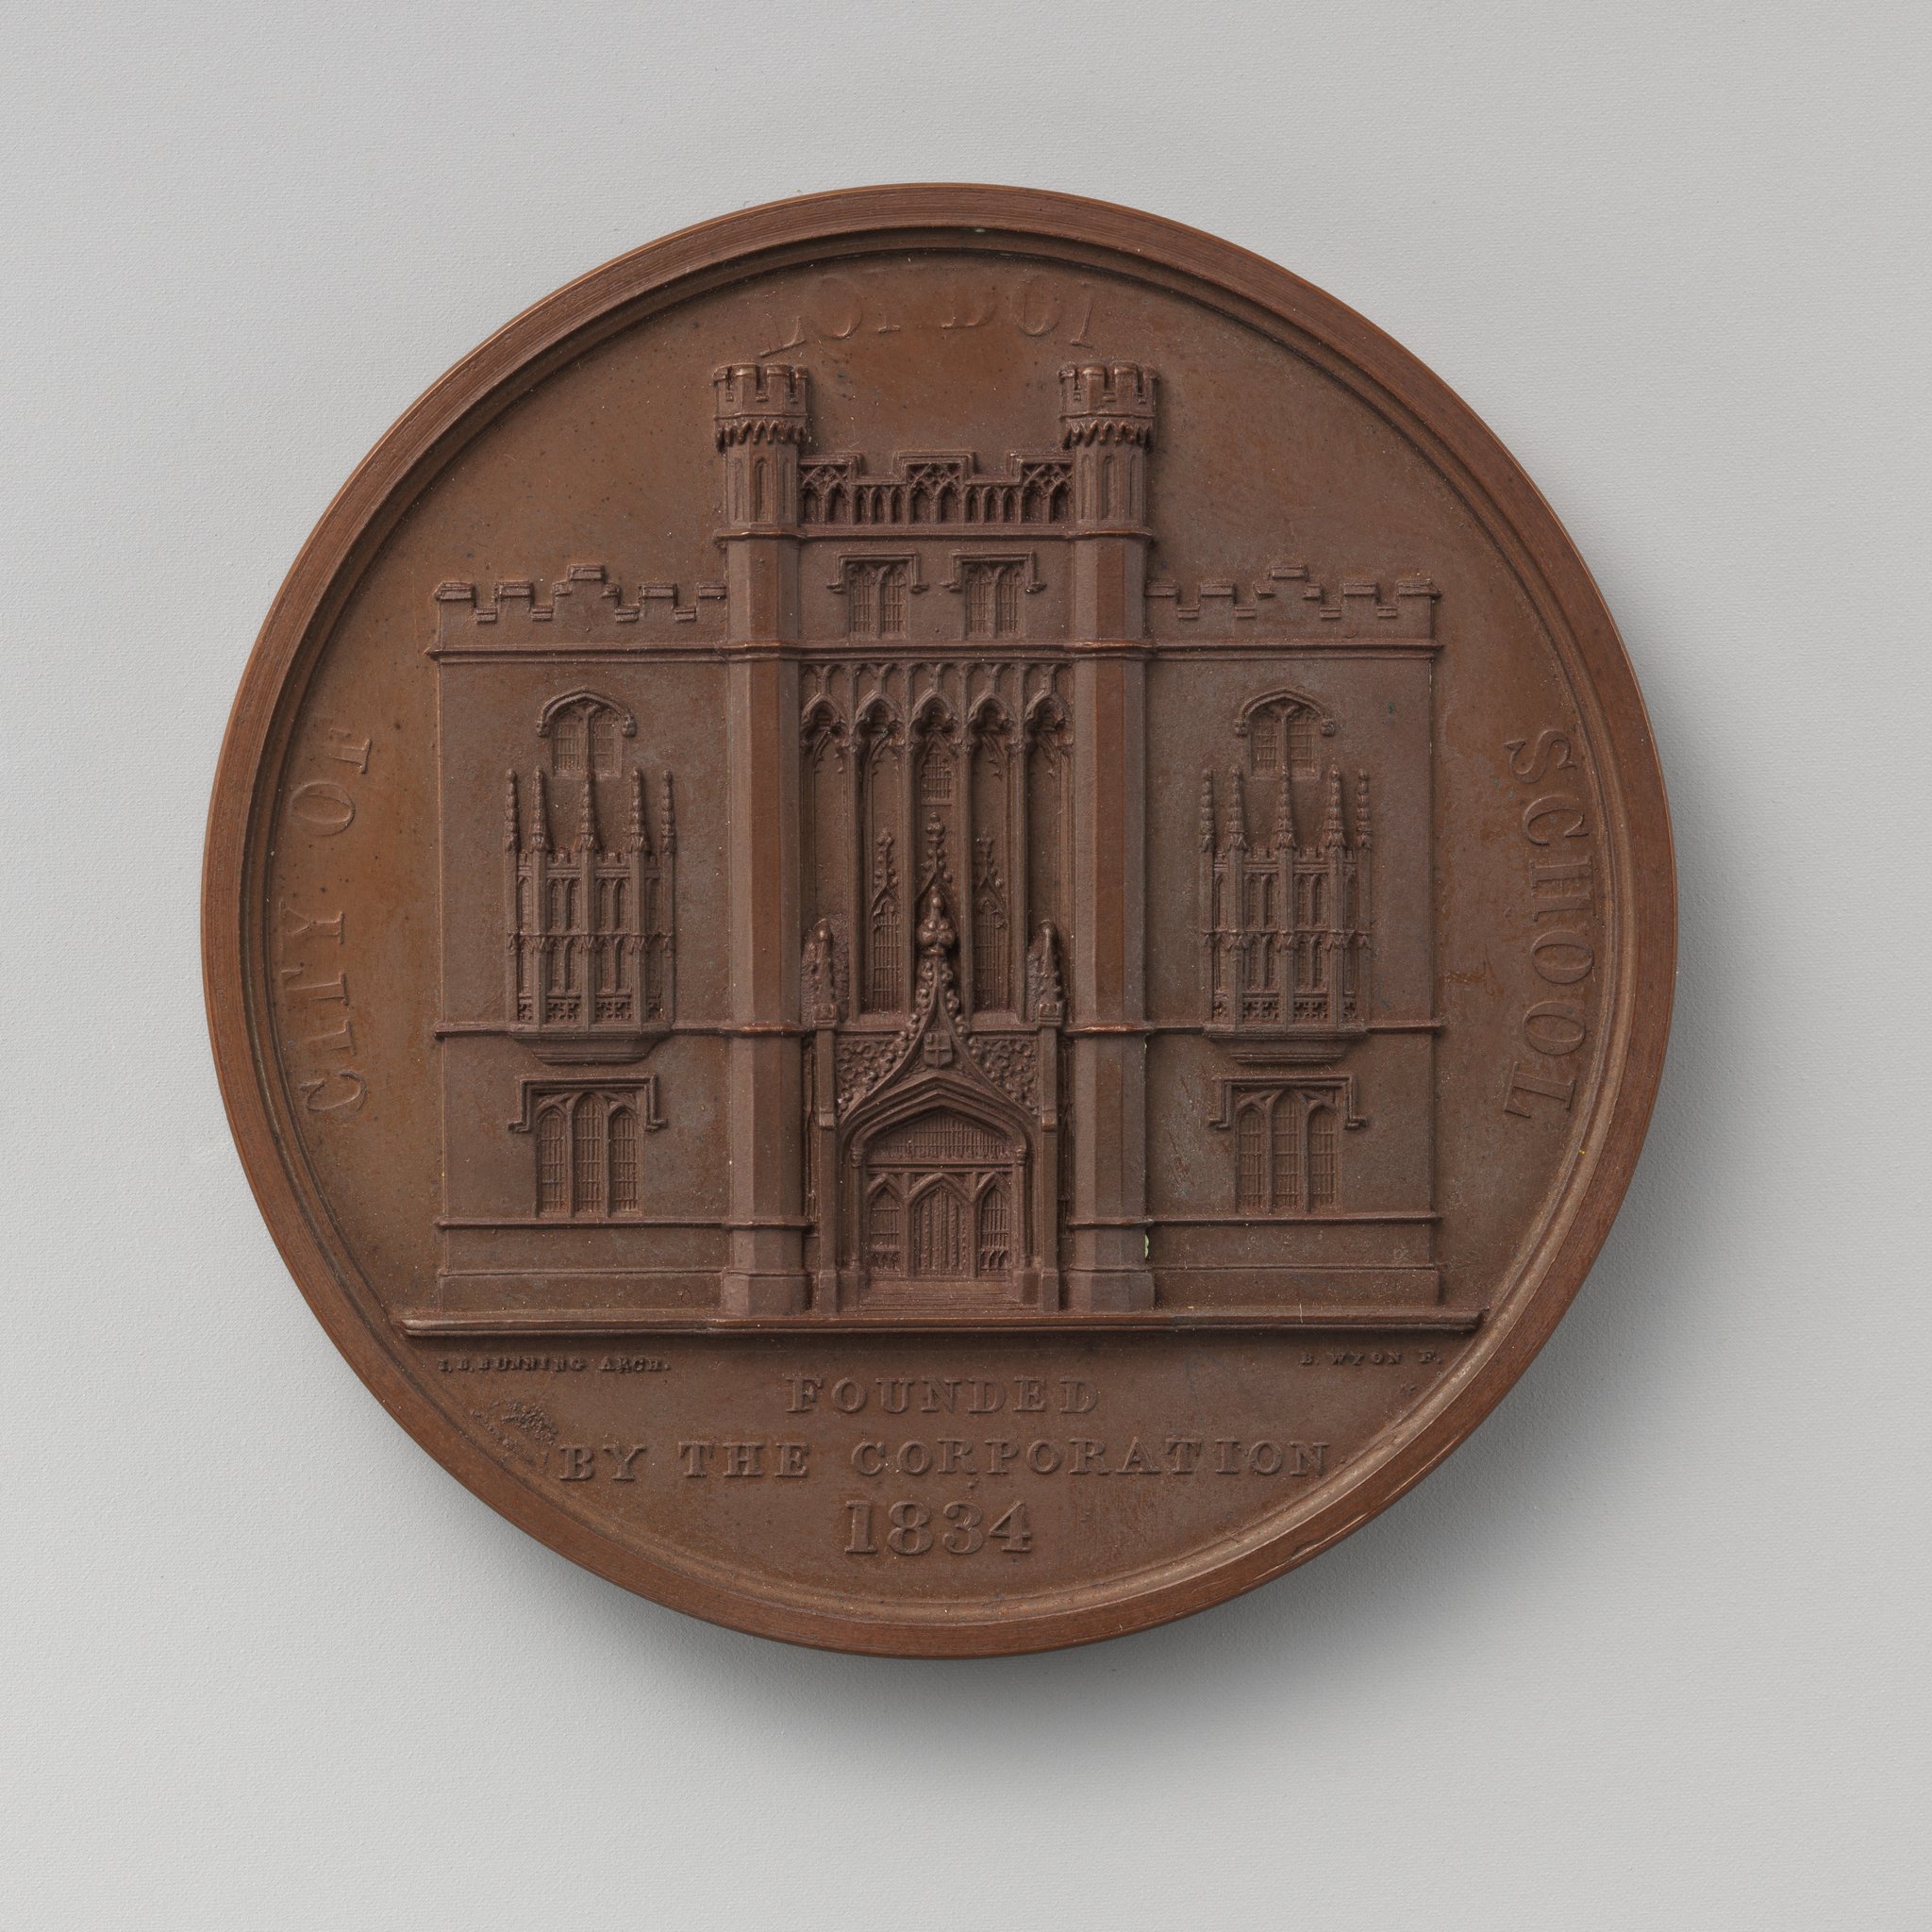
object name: medal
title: To Commemorate the Founding of the Free "City of London School" in 1834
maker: benjamin wyon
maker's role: artist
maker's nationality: british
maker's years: 1802-1858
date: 1834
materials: bronze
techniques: struck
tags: schools,medals